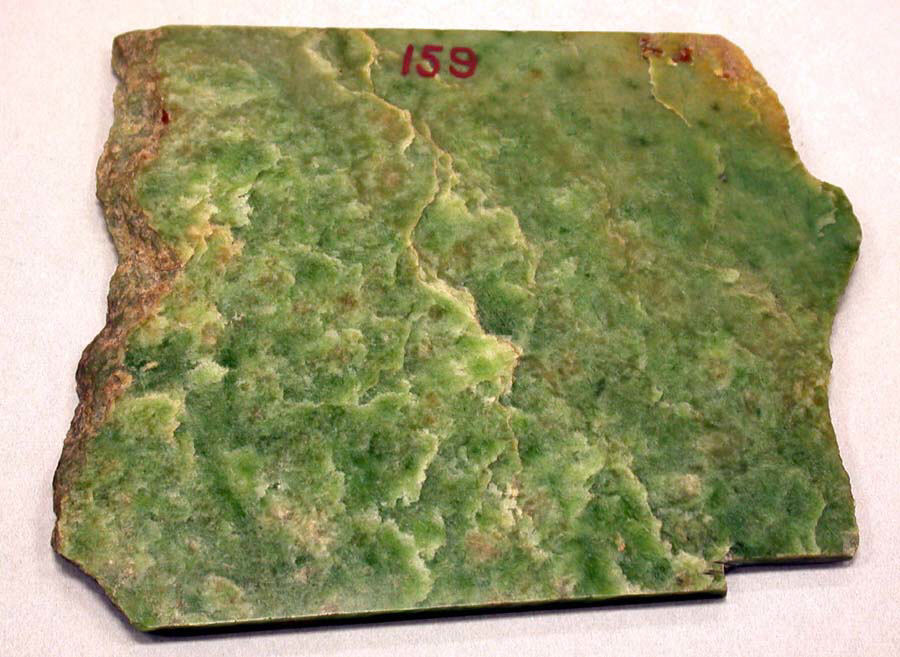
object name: fragment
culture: new zealander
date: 1902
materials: jade